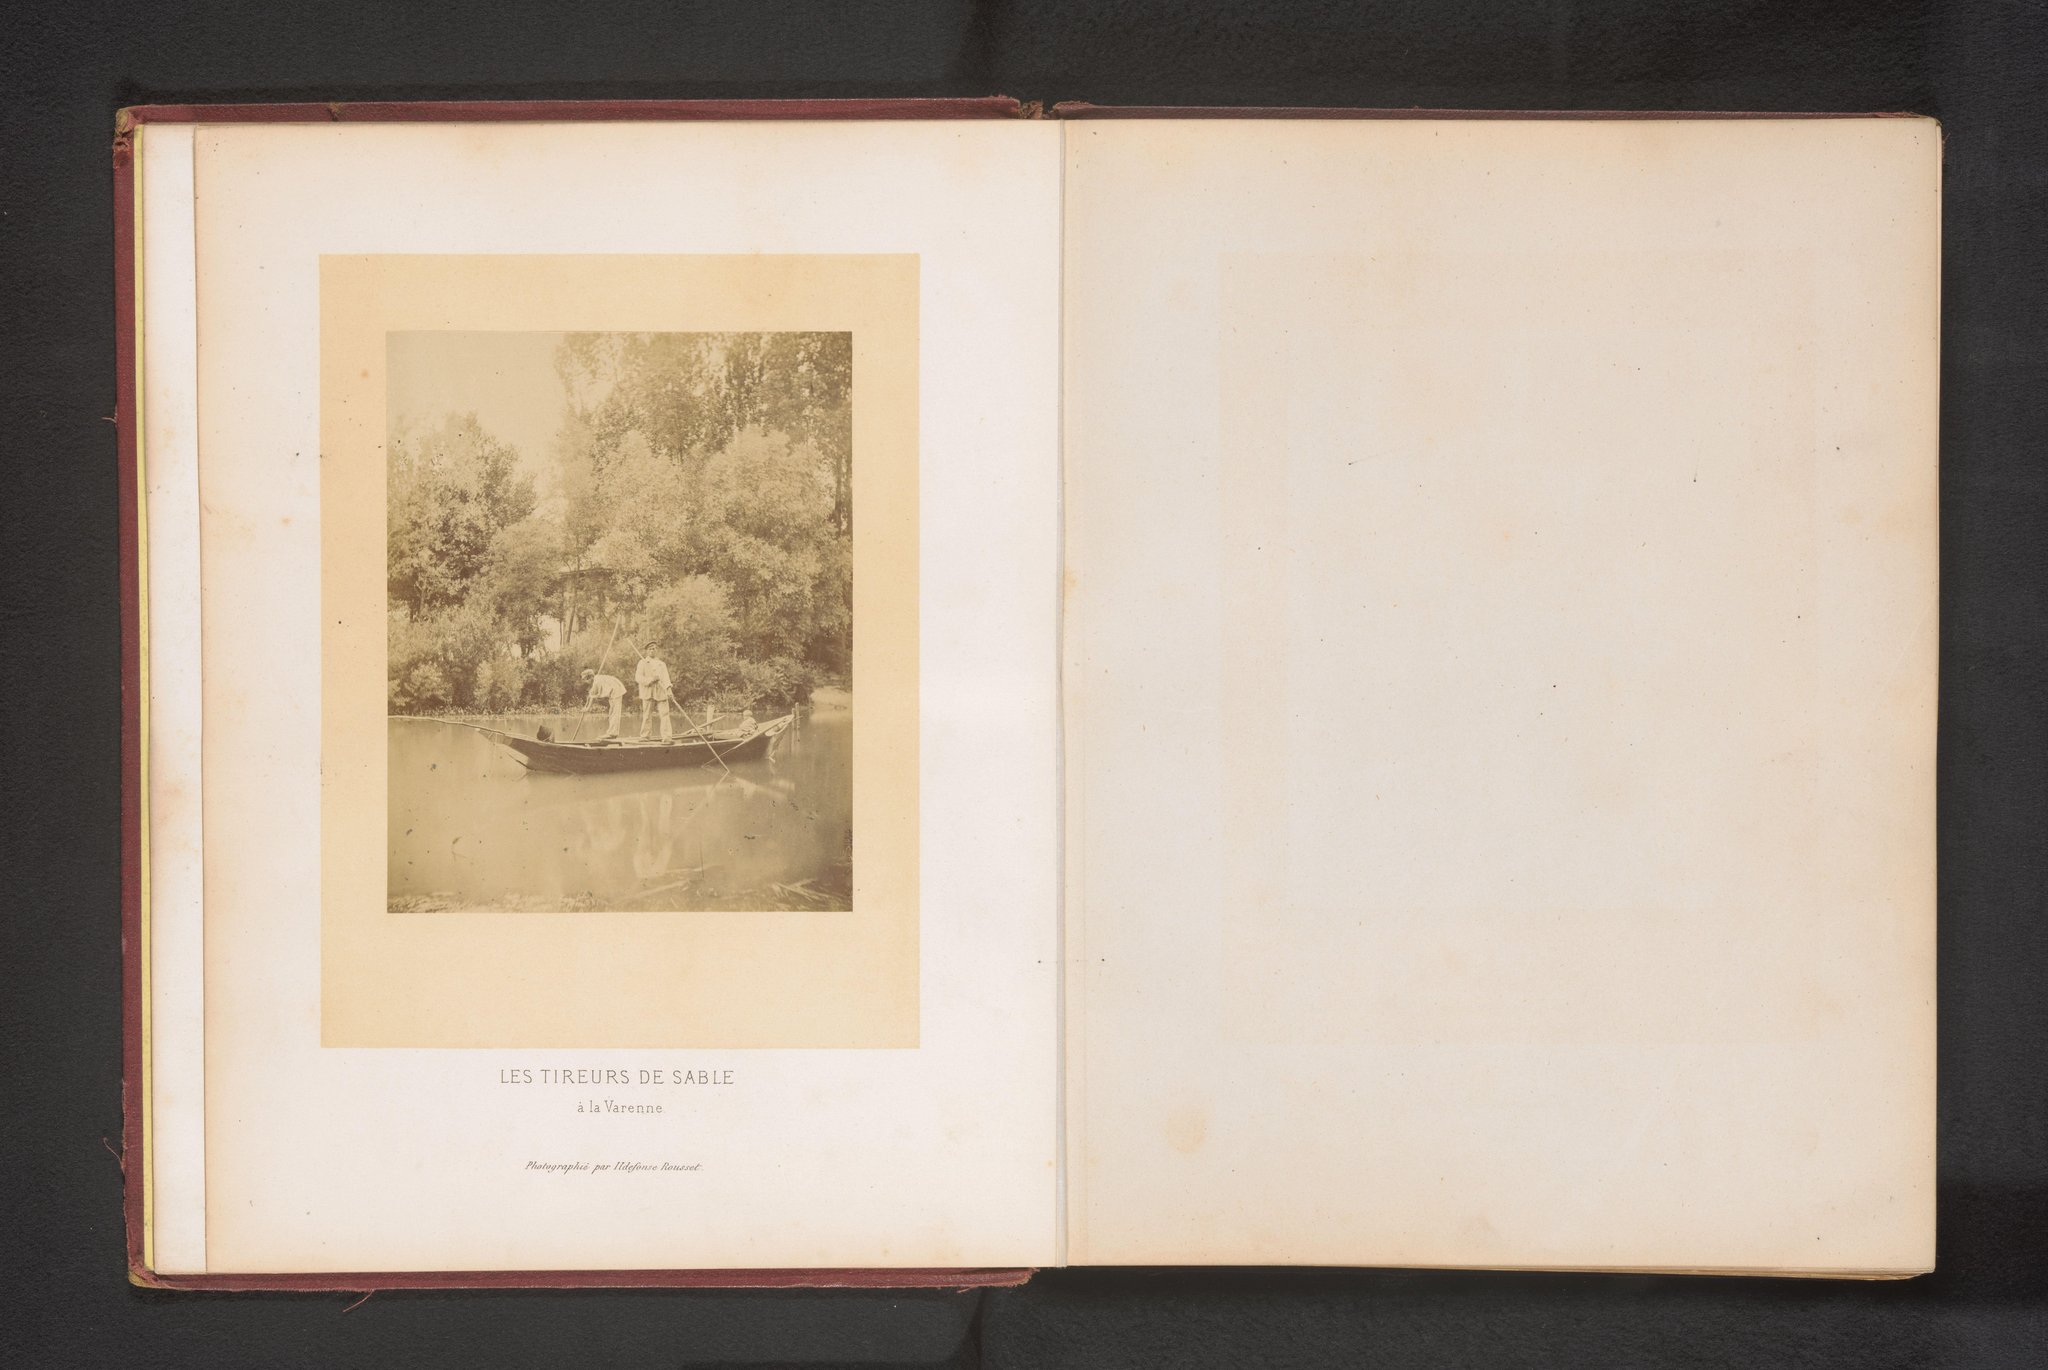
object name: page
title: Les tireurs de sable à la Varenne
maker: ildefonse rousset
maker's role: fotograaf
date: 1860-1865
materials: photographic support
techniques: albumen print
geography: ile-de-france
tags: river, ships (in general), working class, labourers